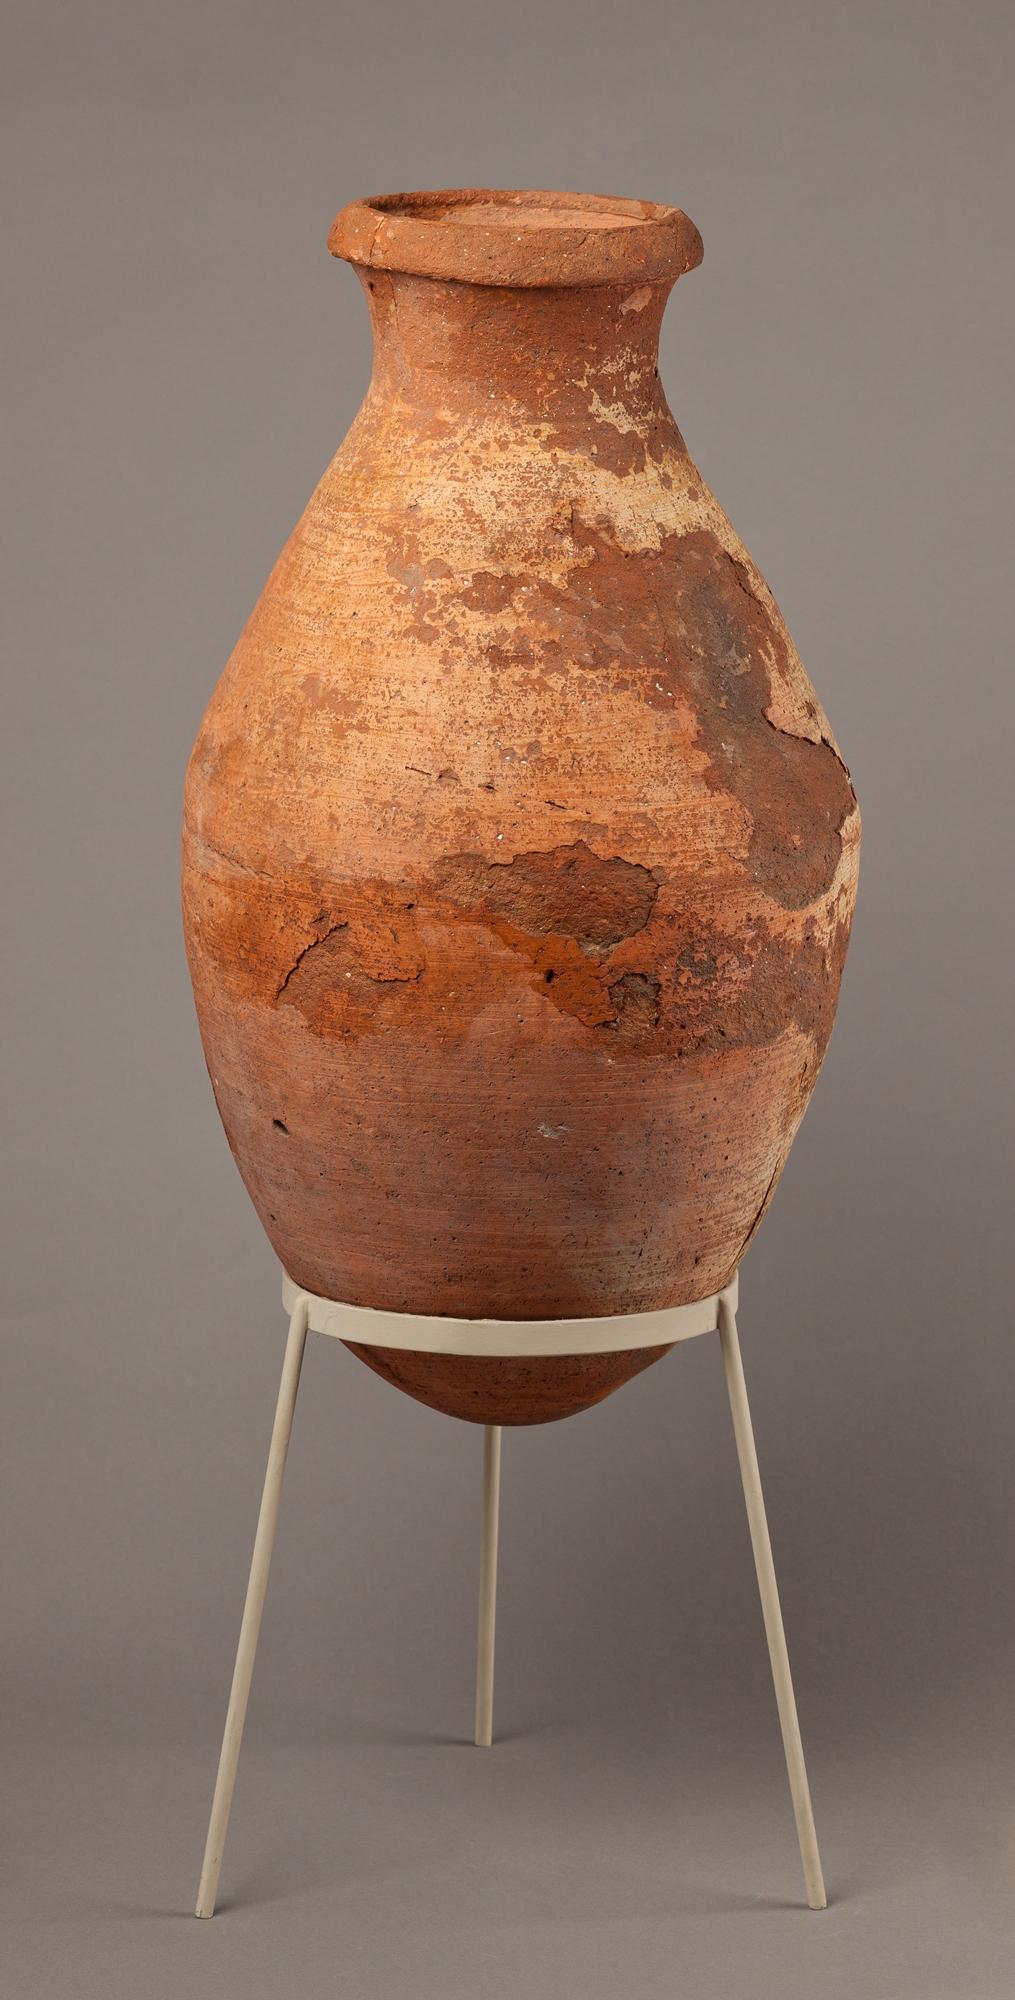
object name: jar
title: Water jar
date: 1550-1295 BCE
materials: pottery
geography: egypt